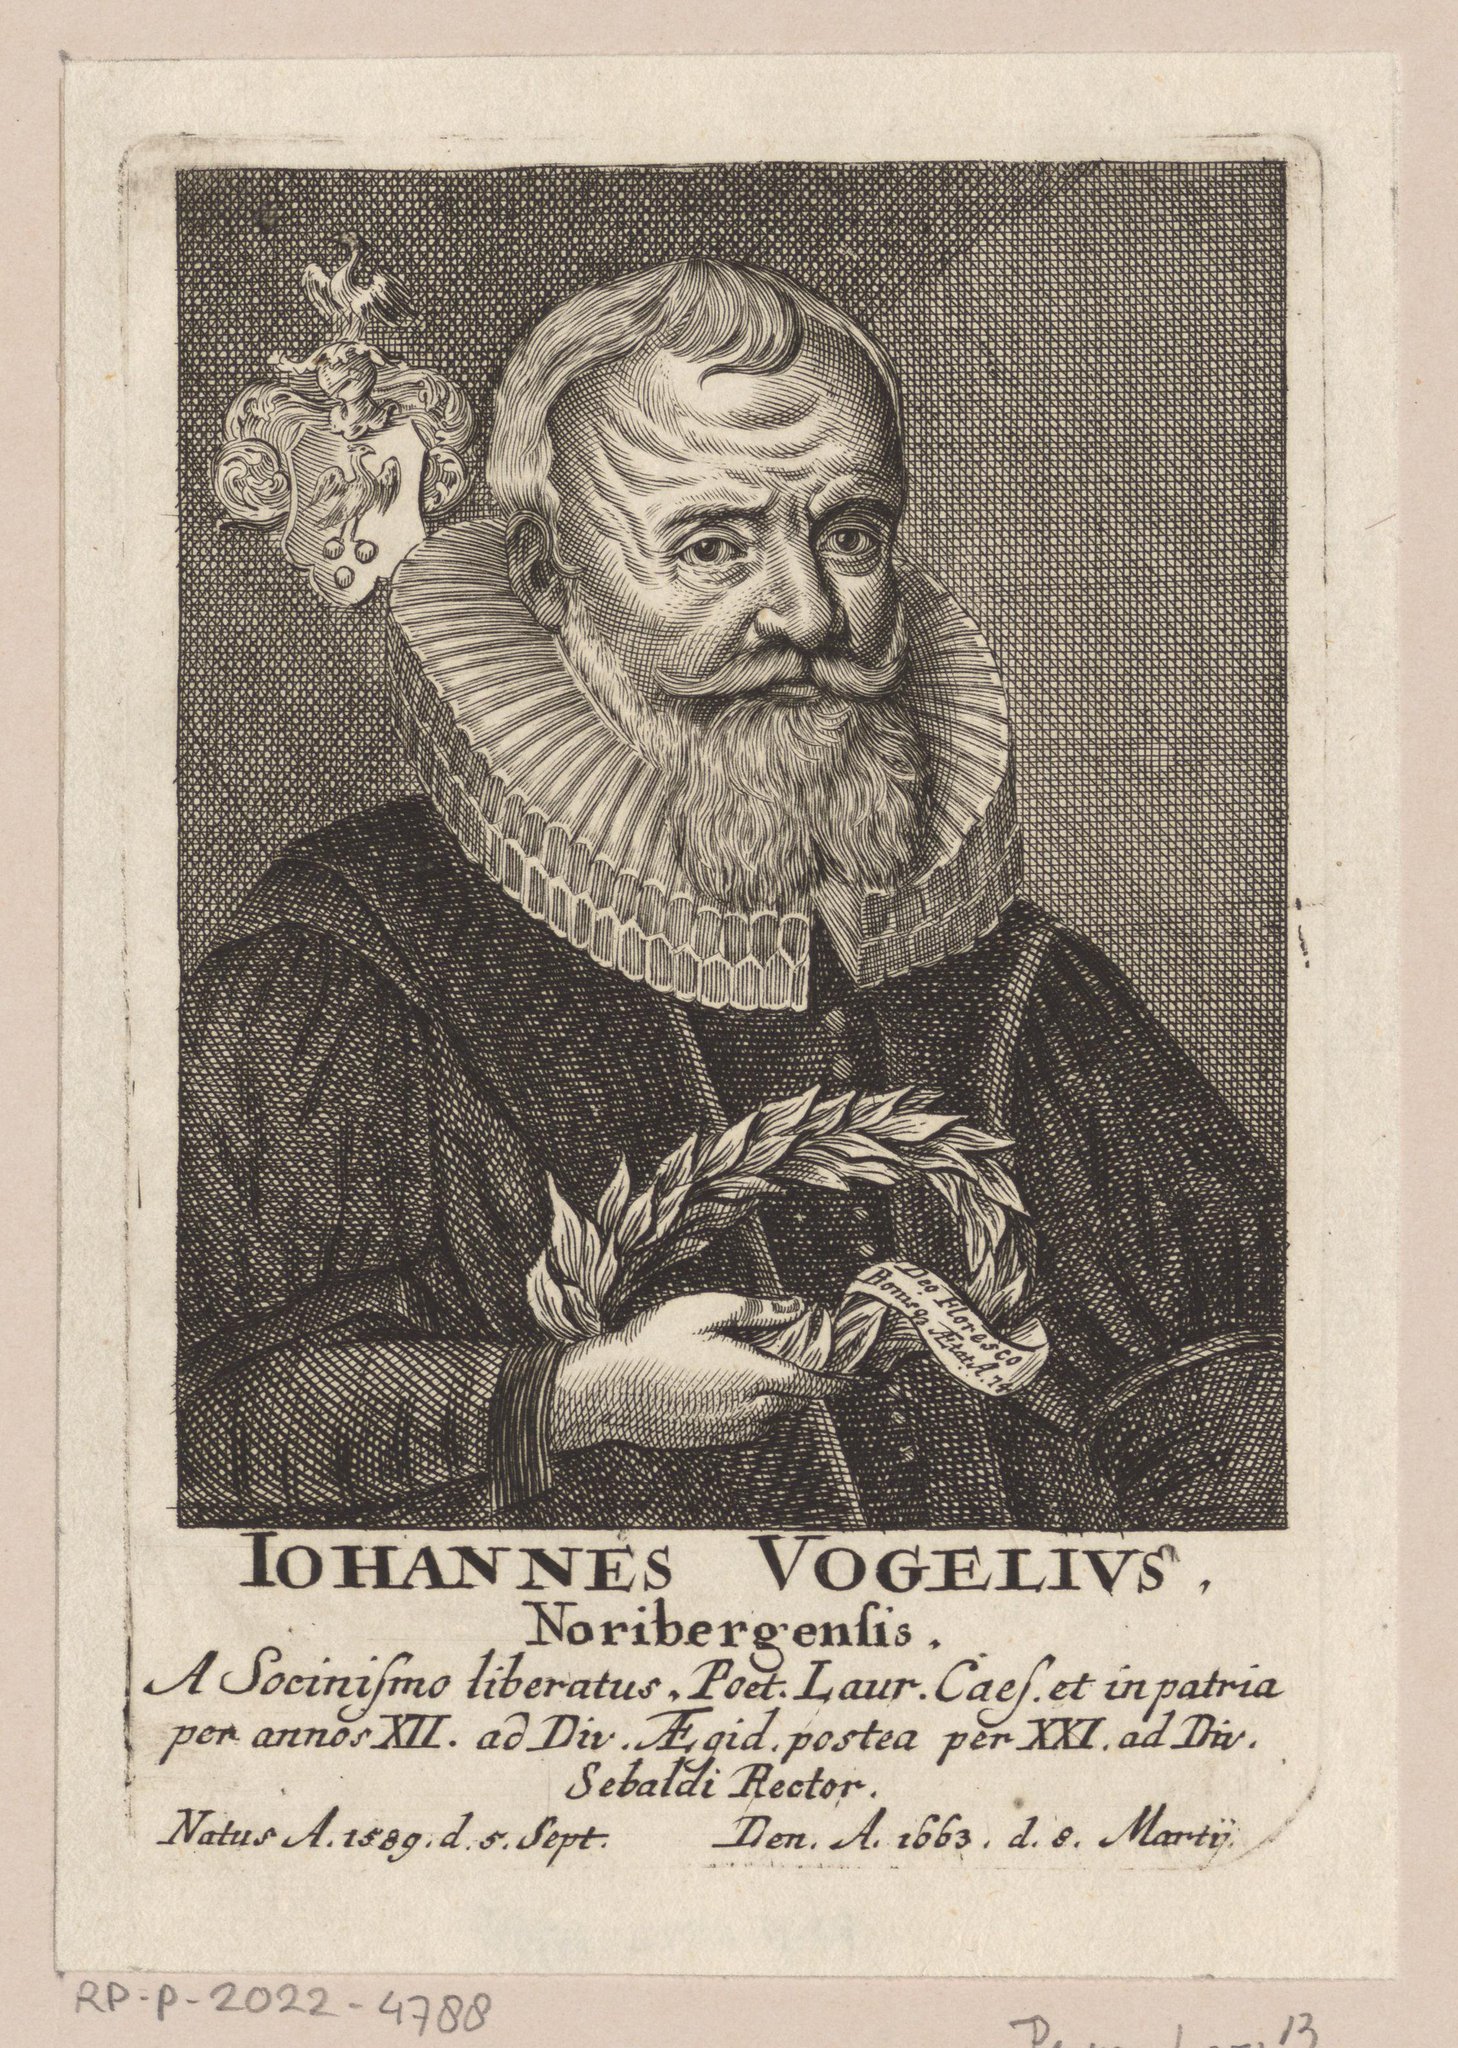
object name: print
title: Portret van Johann Vogel op 74-jarige leeftijd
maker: Anonymous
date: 1720-1725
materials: paper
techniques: engraving, etching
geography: germany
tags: johann vogel, historical persons, portrait of a writer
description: Prent mogelijk uit: Roth-Scholtz, Friedrich. Icones virorum omnium ordinum eruditione omnique item genere (...). Neurenberg: erven Johann Daniel Tauber, 1725.